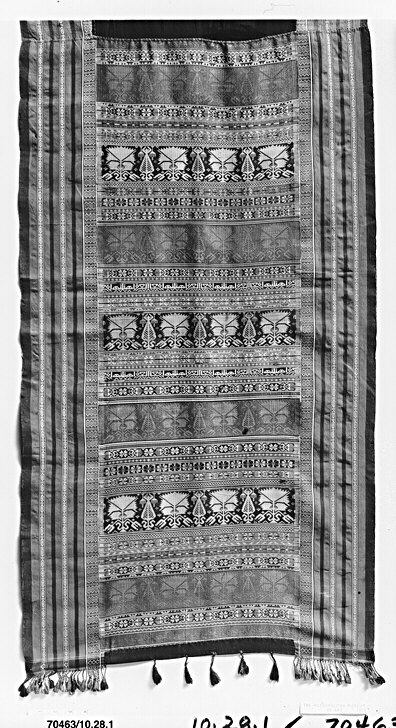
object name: headcovering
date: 1801-1900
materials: silk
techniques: weave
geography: tunisia